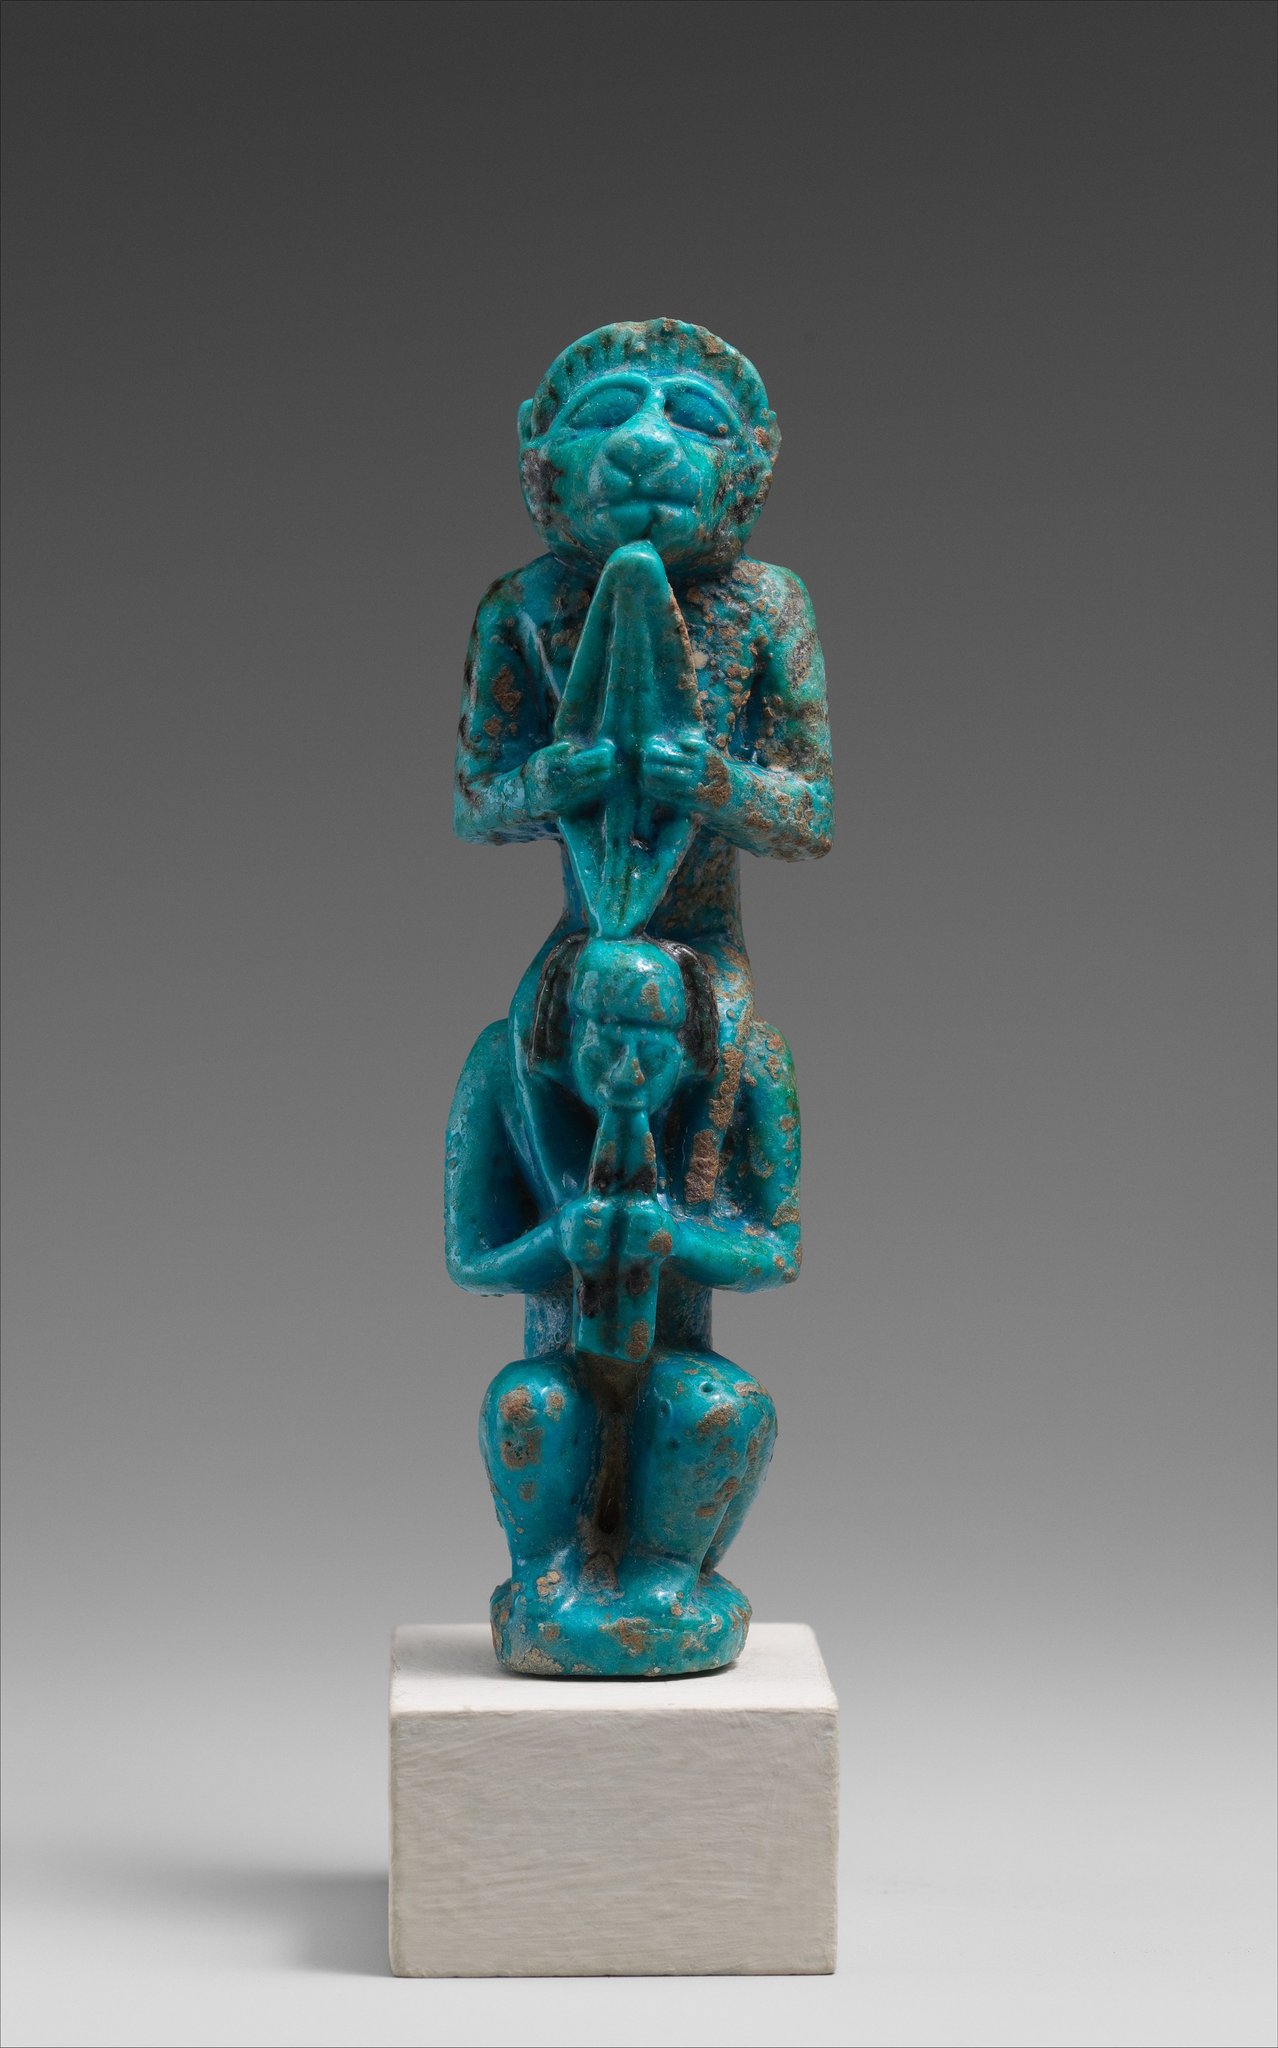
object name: amulet, monkey, musician, flute, harp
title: Monkey and Man Playing Instruments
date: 1070-664 BCE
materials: faience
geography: egypt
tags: musical instruments,men,monkeys